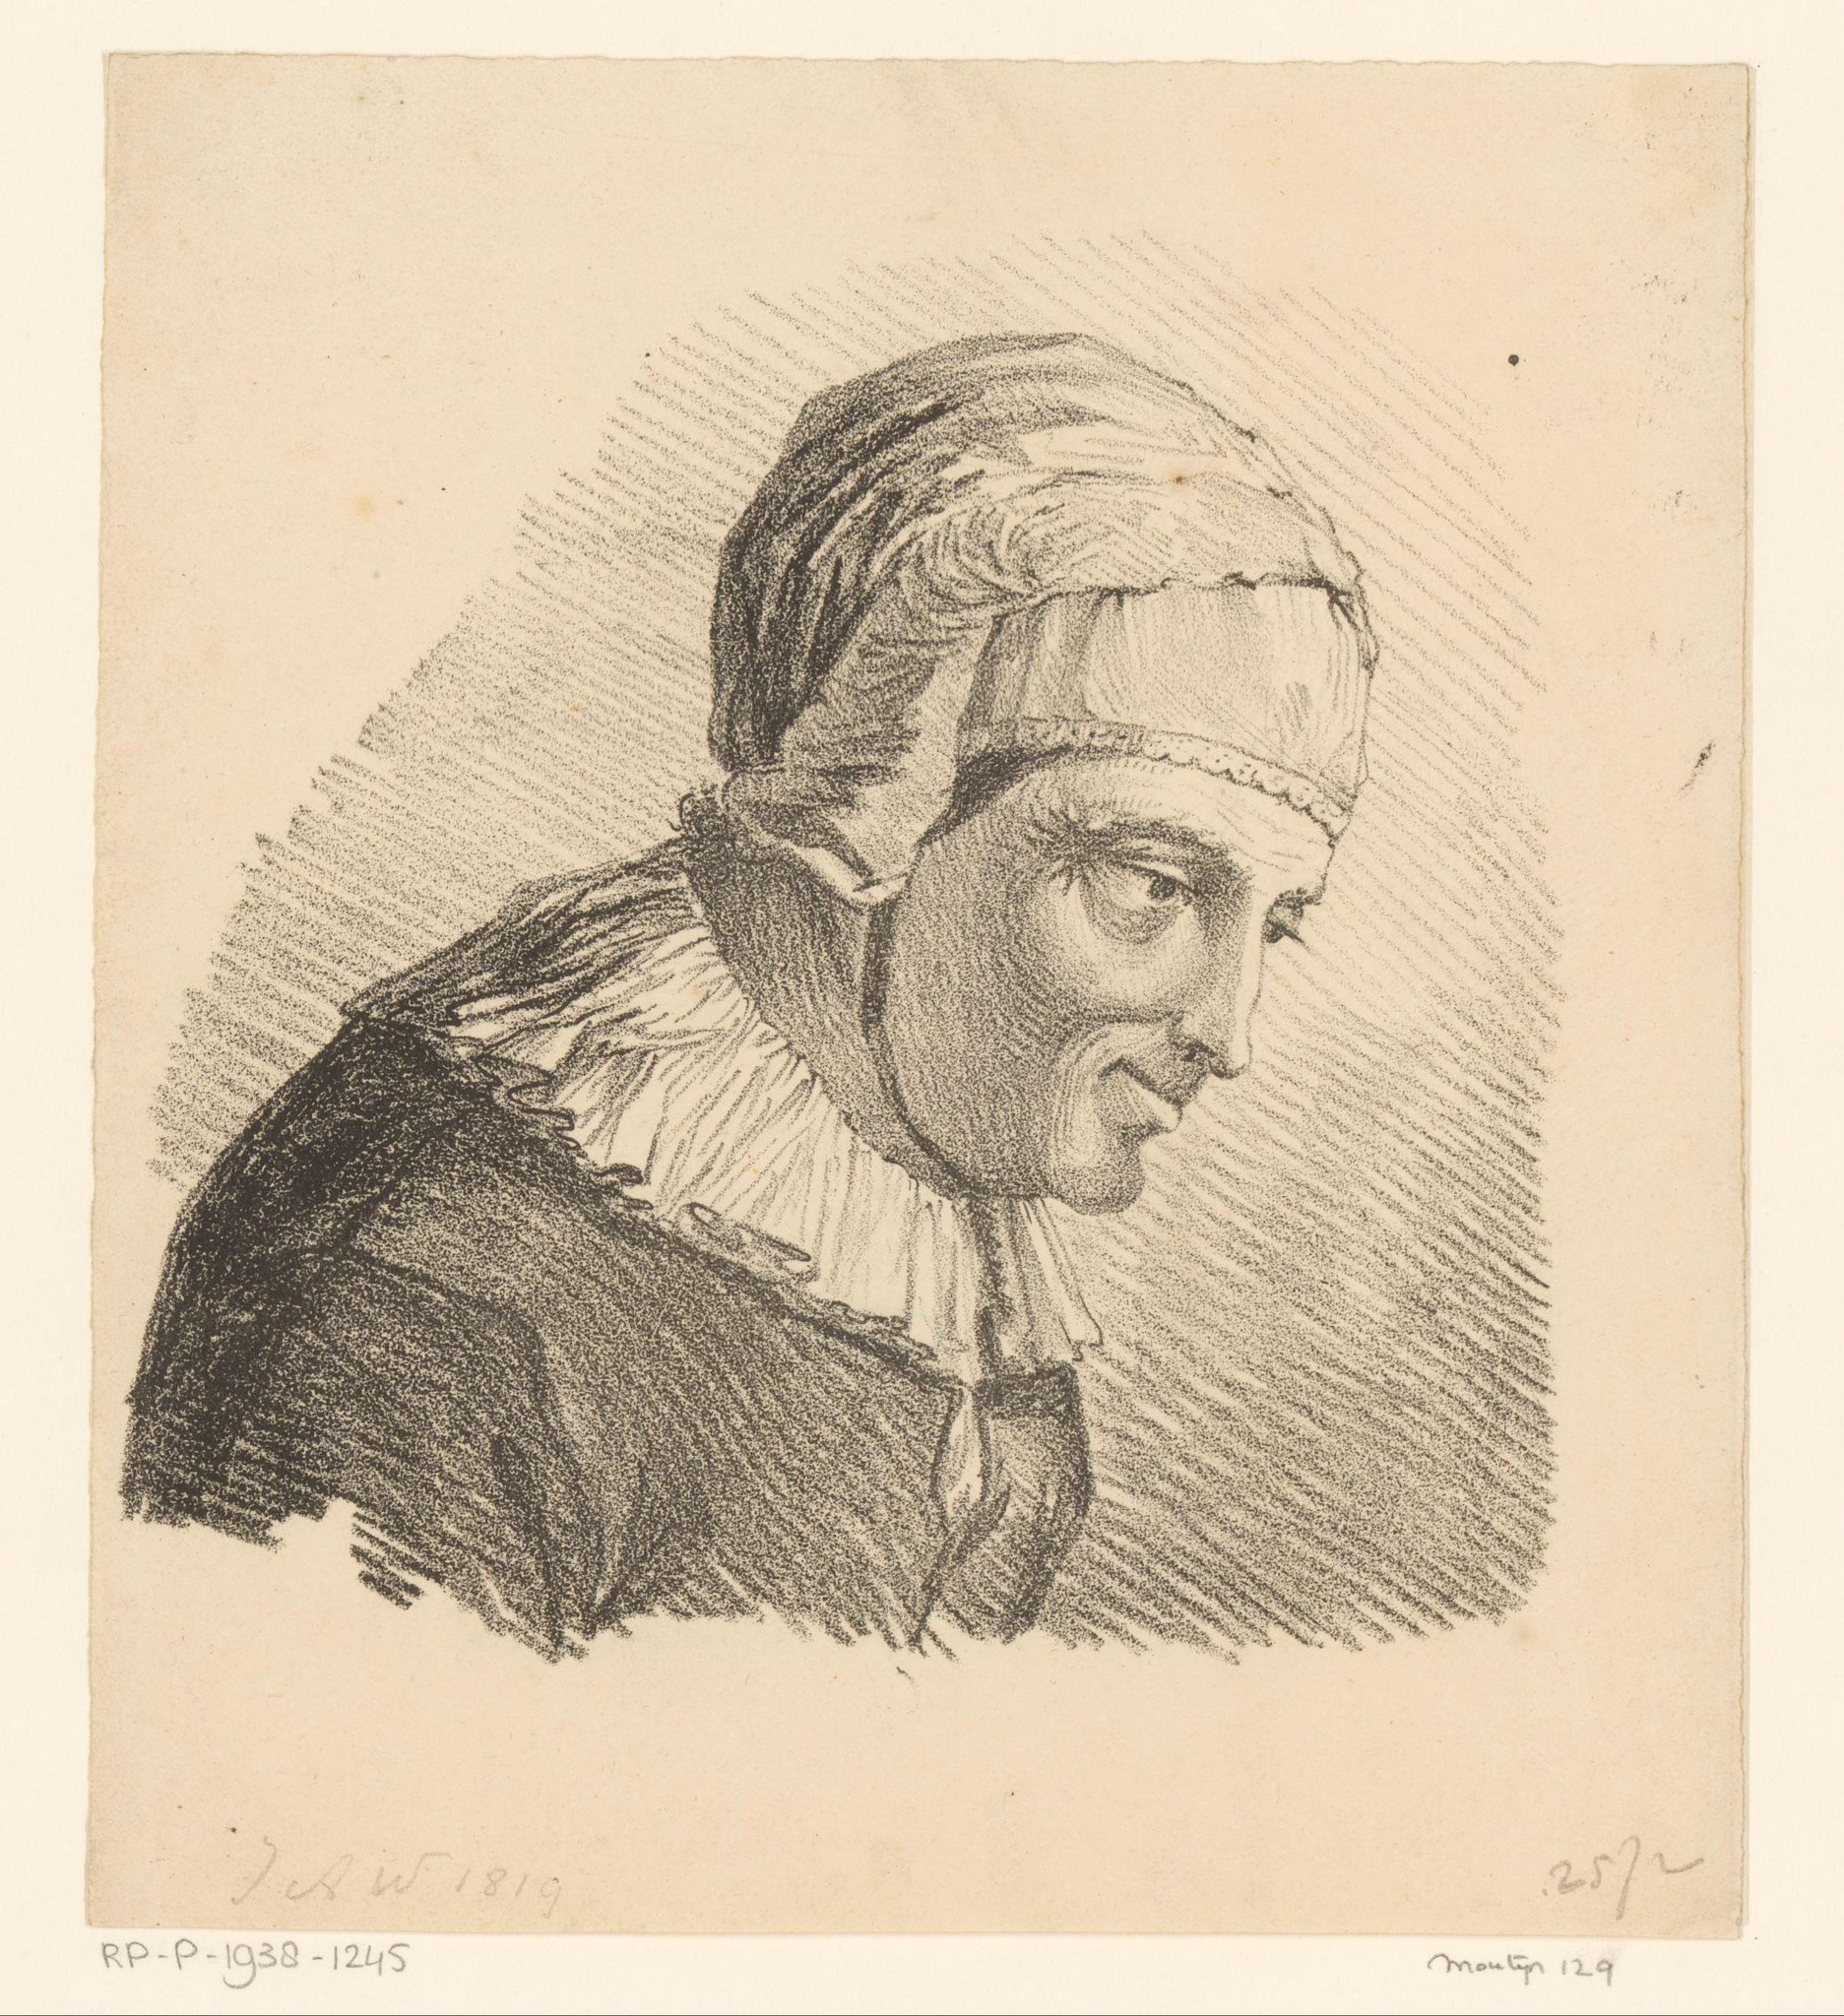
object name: print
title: Vrouw met muts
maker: jacobus adrianus weiland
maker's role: print maker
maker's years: 1784-1869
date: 1819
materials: paper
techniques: lithograph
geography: netherlands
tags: adult woman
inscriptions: collector's mark: Lugt 2760, collector's mark: Lugt 2228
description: Een vrouw met kornet en geplooide kraag naar rechts onder kijkend.